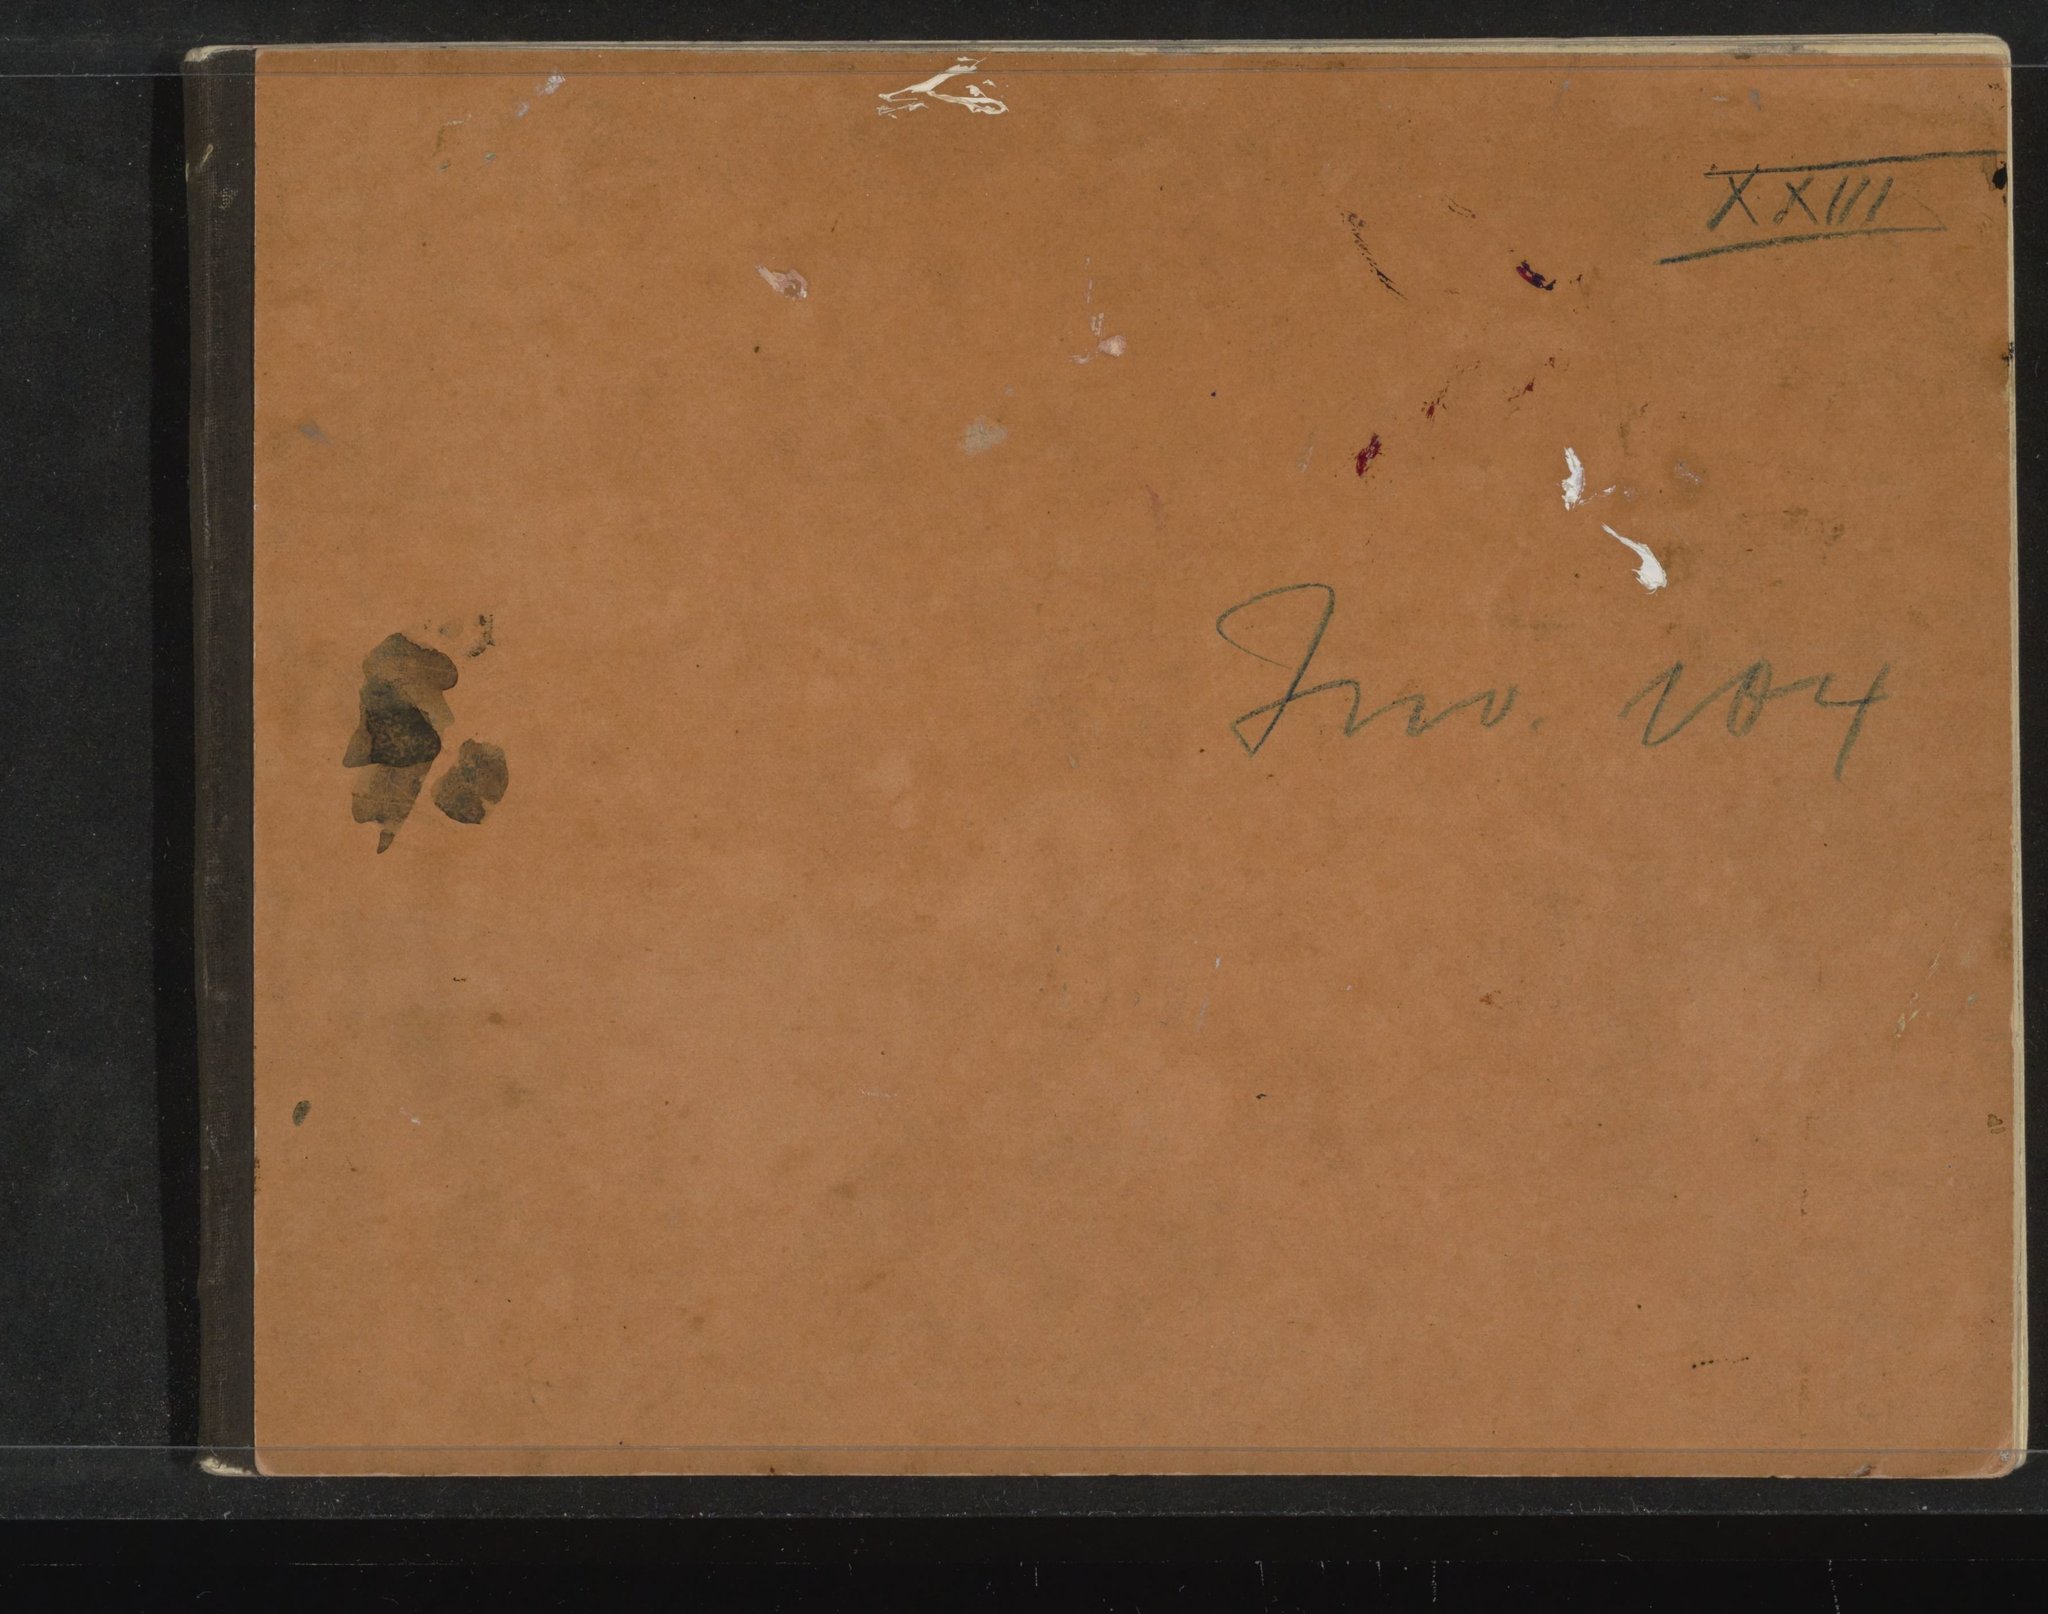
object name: sketchbook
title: Schetsboek XXIII met 20 bladen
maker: isaac israels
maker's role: draughtsman, painter, print maker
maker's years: 1865-1934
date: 1875-1934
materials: cardboard, chalk, ink, linen, paper, pencil, watercolor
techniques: brush, pen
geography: the hague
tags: adult woman, anonymous historical person portrayed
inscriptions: collector's mark: Lugt 2228, label: ‘Le Franc & Cie Paris’, retailer's mark: ‘W.M. Stam / Papestraat 15 / Den Haag / Telefoon 4706’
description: Schetsboek nr. XXIII bestaande uit 20 bladen met figuurstudies, vrouwelijke naakten en portretten. Achterin een losse tekening.